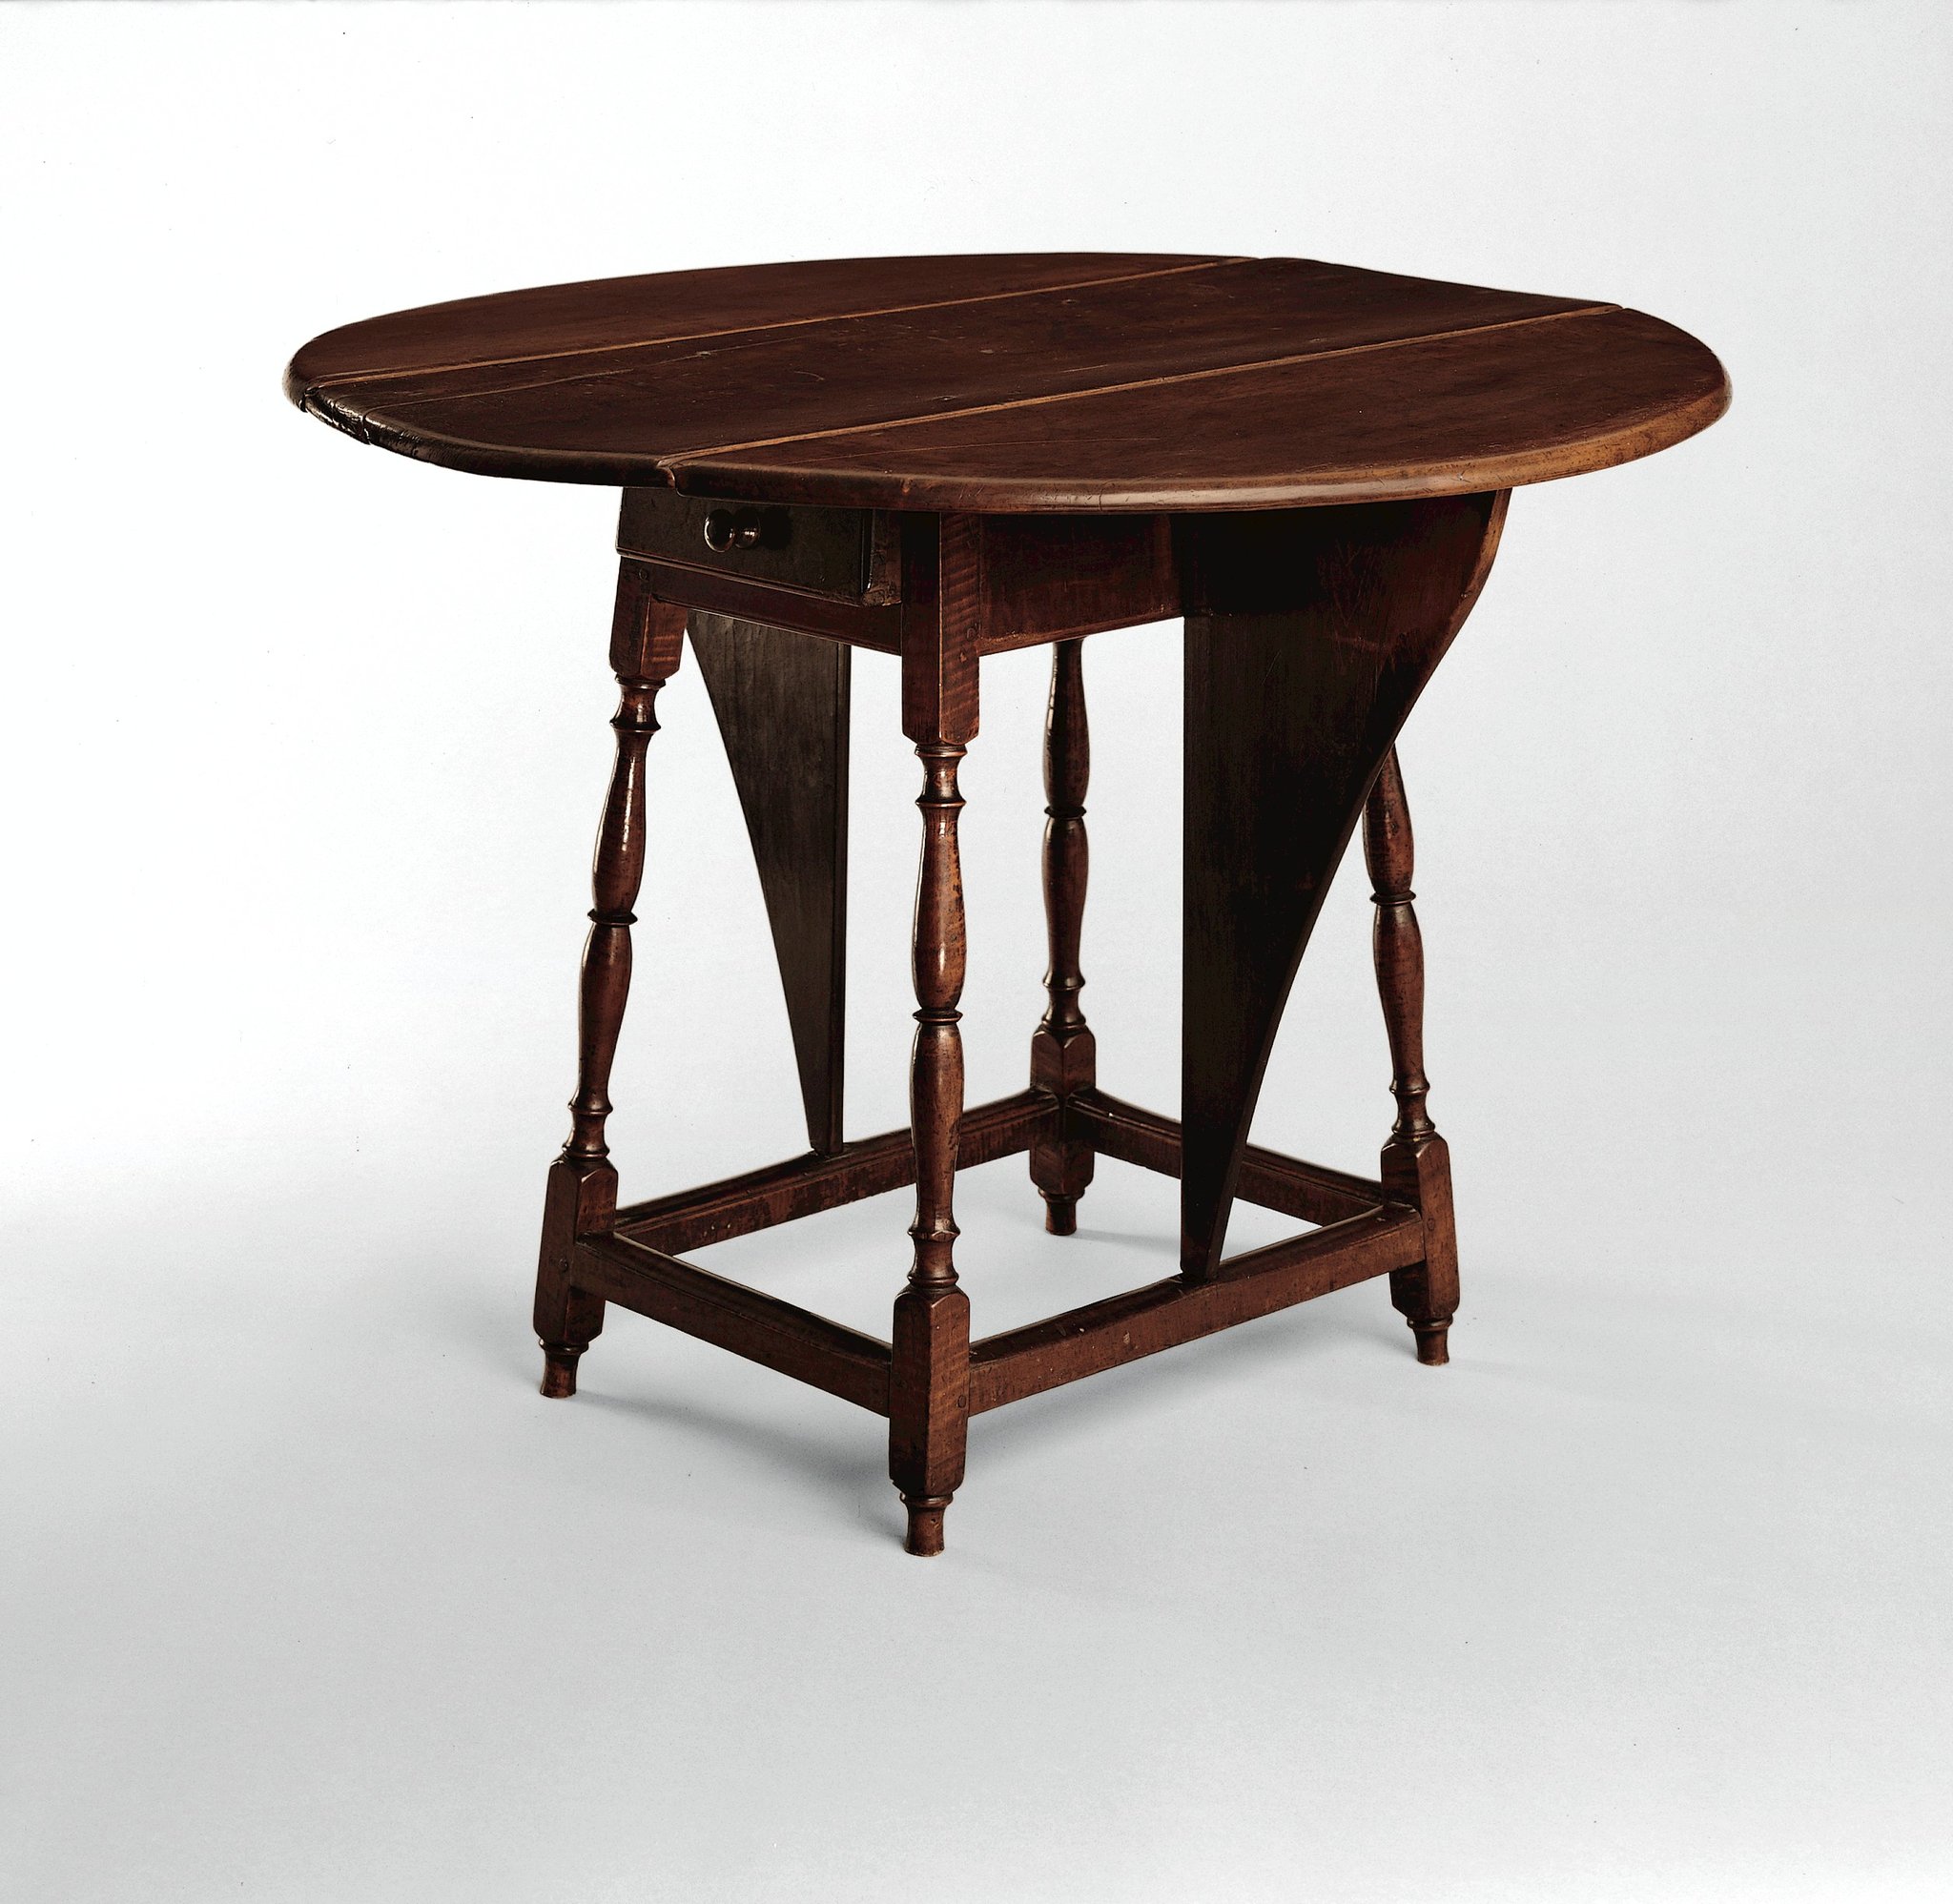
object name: drop leaf table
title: Drop-leaf Table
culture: american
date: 1700-1800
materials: wood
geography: united states